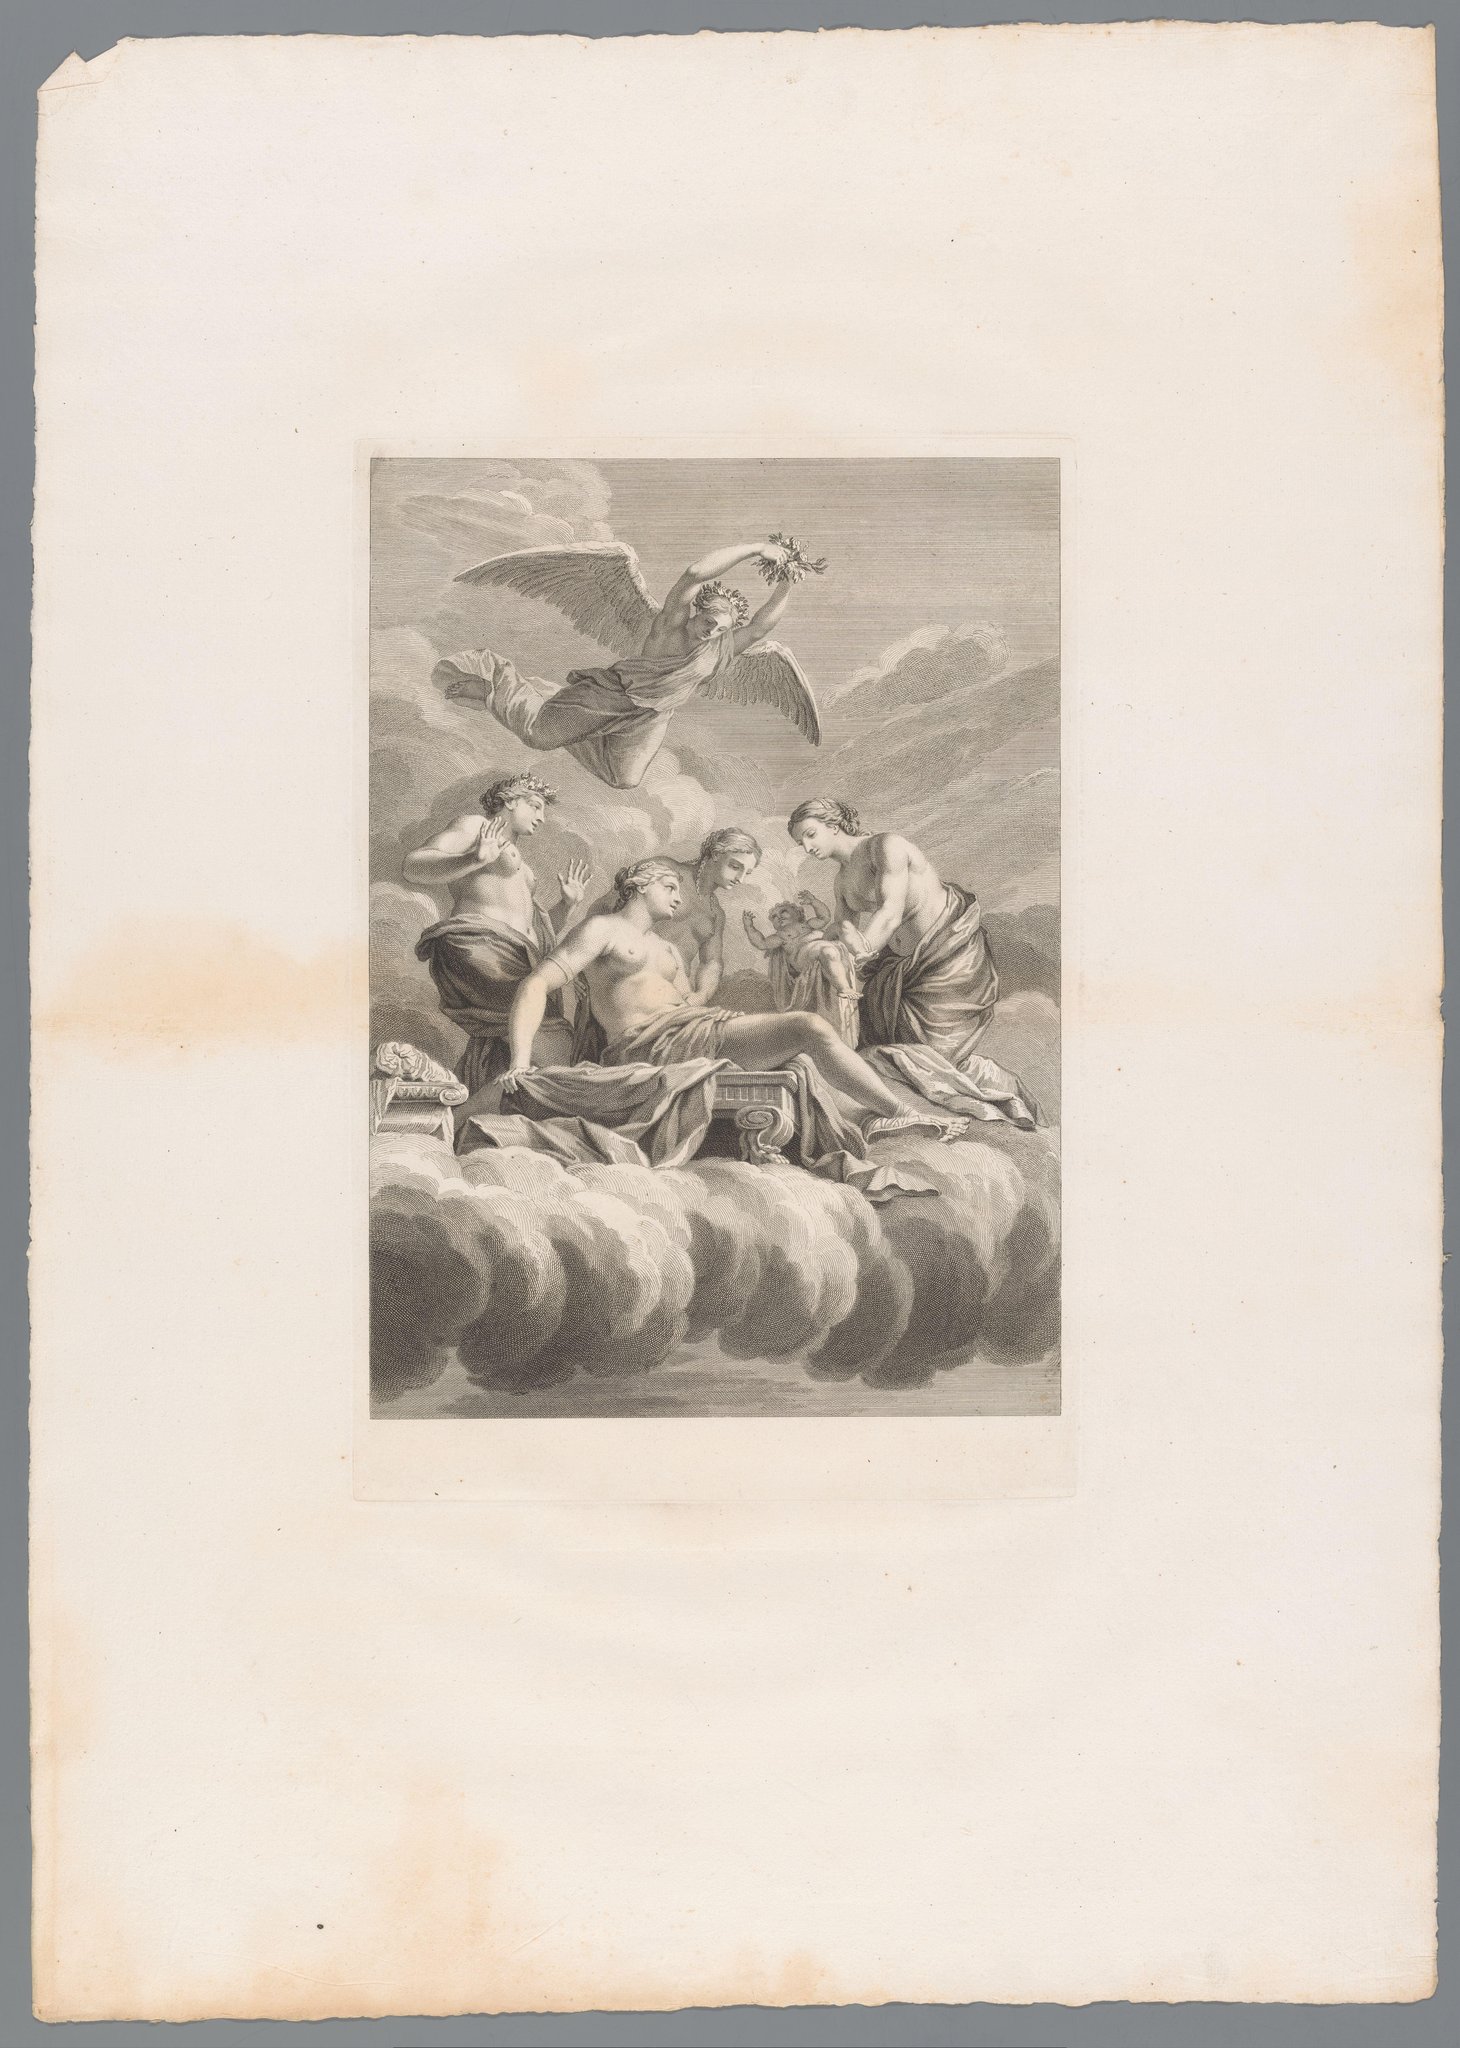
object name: print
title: Les peintures de Charles le Brun et d'Eustache Le Sueur qui sont dans (...) la maison du Président Lambert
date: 1740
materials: paper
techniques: engraving, etching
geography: paris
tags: early life, prime youth of cupid - birth, graces (charites), generally three in number; 'gratie' (ripa), (story of) venus (aphrodite), hours (horae), seasons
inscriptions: collector's mark: Lugt 2228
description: Een van de drie gratieën presenteert de pasgeboren Amor aan zijn moeder Venus. De twee andere gratieën bewonderen het kind. De personificatie van het uur van de geboorte strooit bloemen. Naar het schilderij in het Cabinet de l'Amour van het Hôtel Lambert. Prent maakt deel uit van een serie prenten naar de schilderijen in het Hôtel Lambert te Parijs.